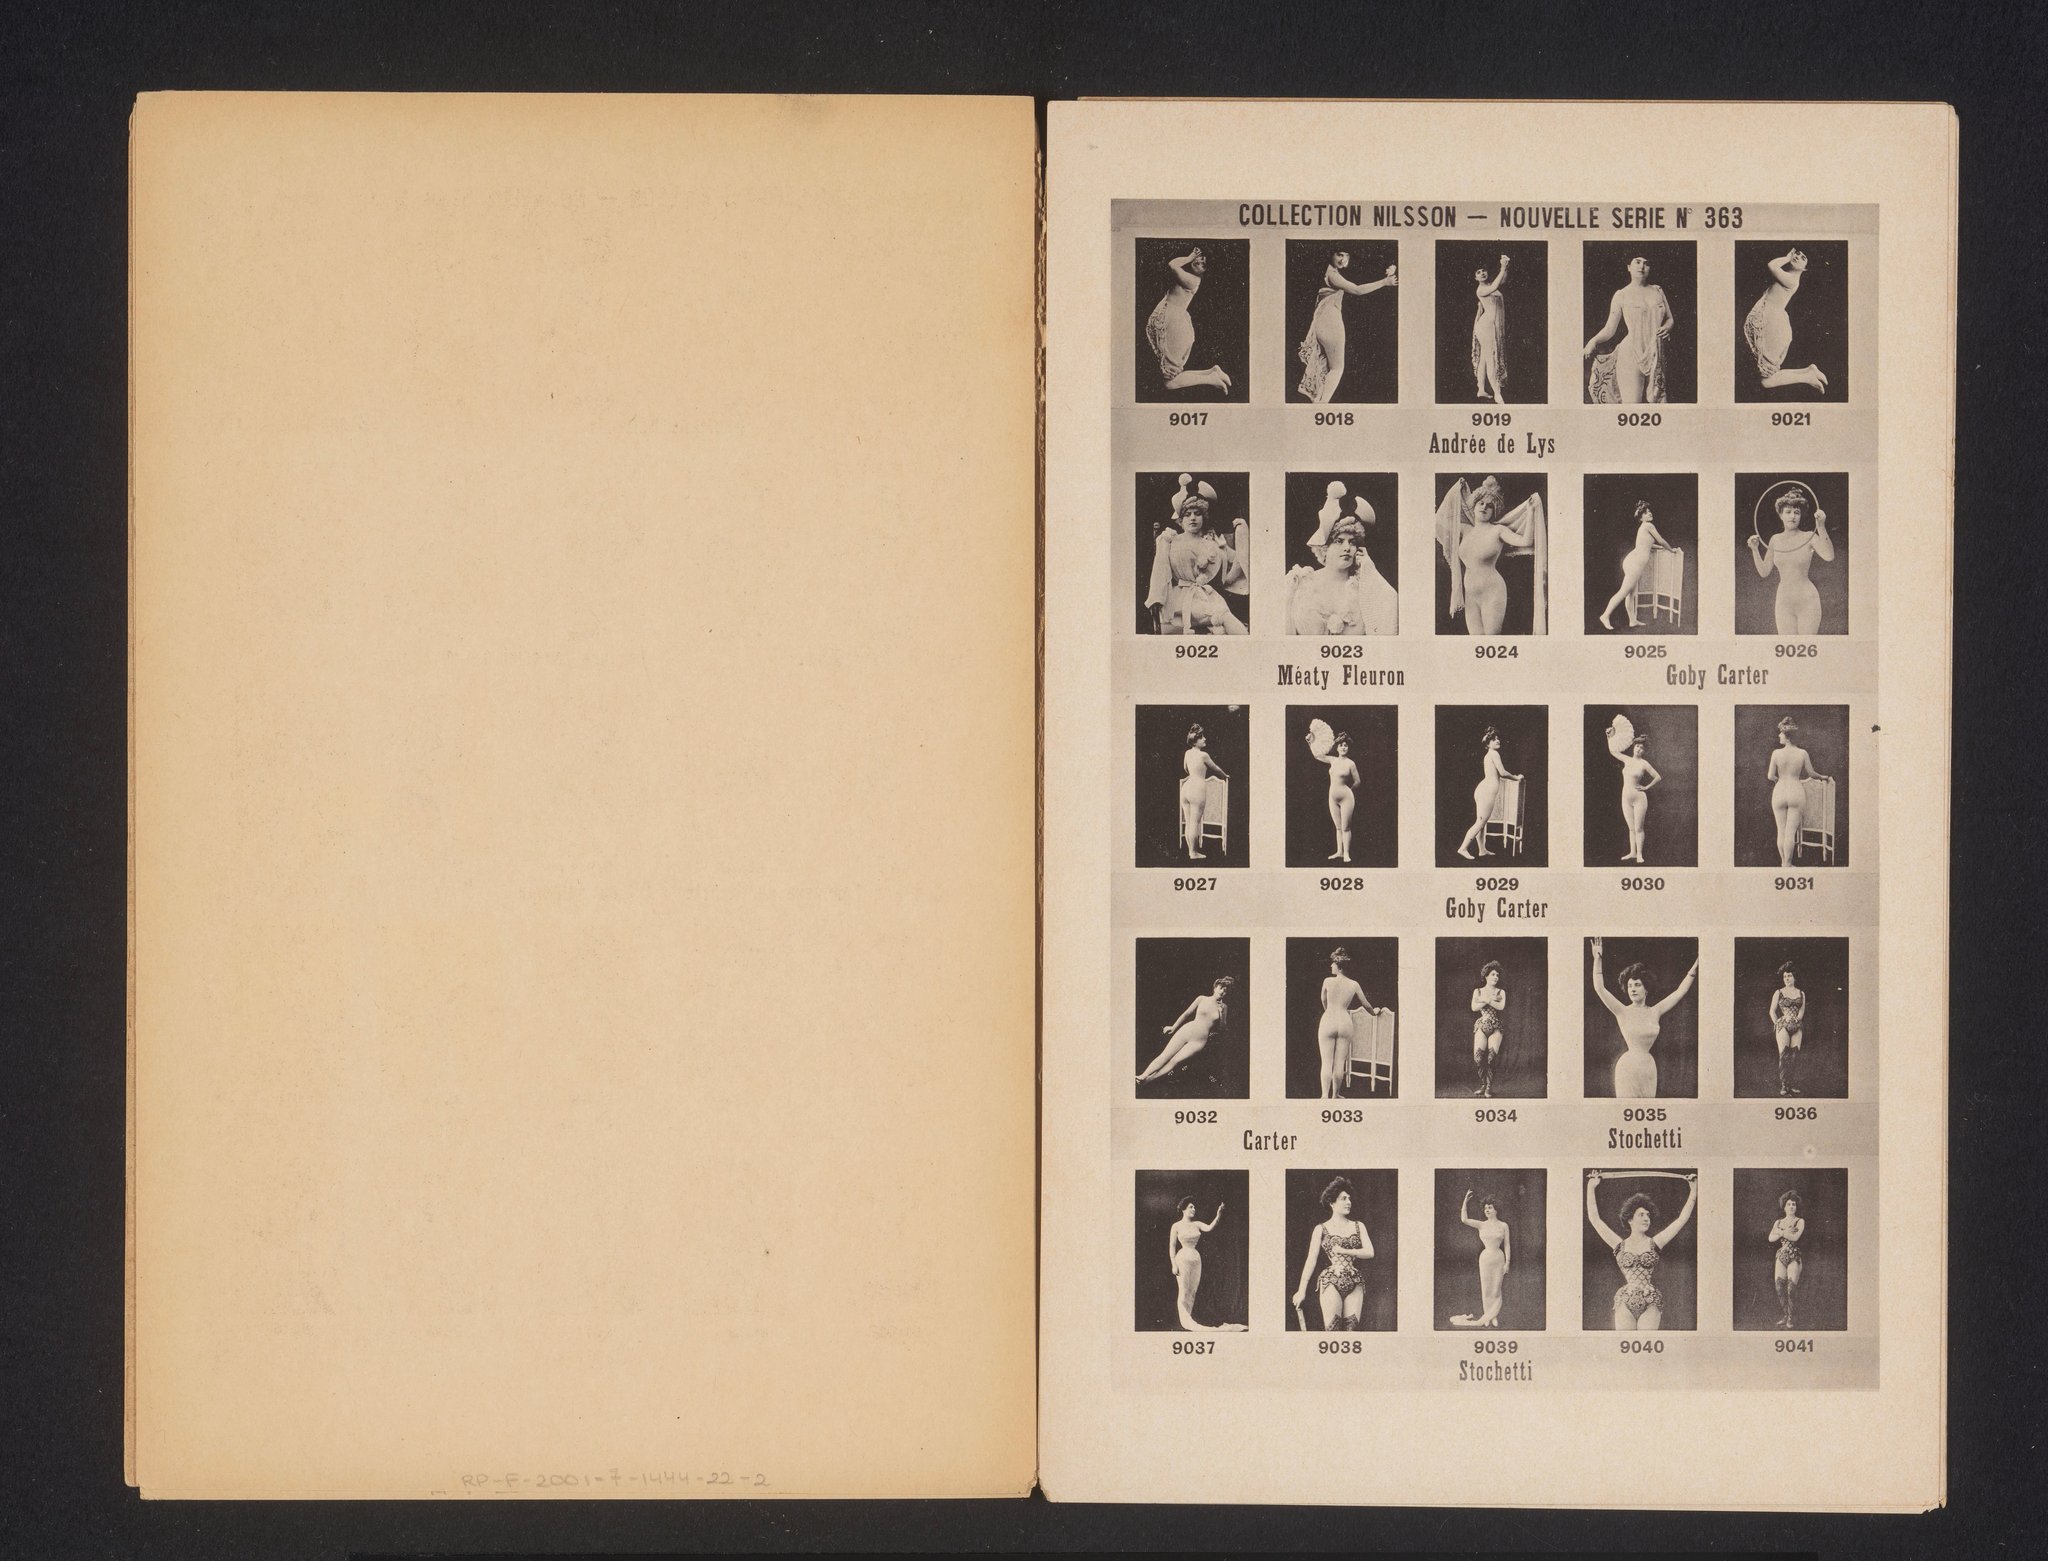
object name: photomechanical print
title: 25 portretten van Andrée de Lys, Méaty Fleuron, Goby Carter en Stochetti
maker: Anonymous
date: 1895-1900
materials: paper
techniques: photograph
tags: historical persons - bb - woman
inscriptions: number: ‘No 363’